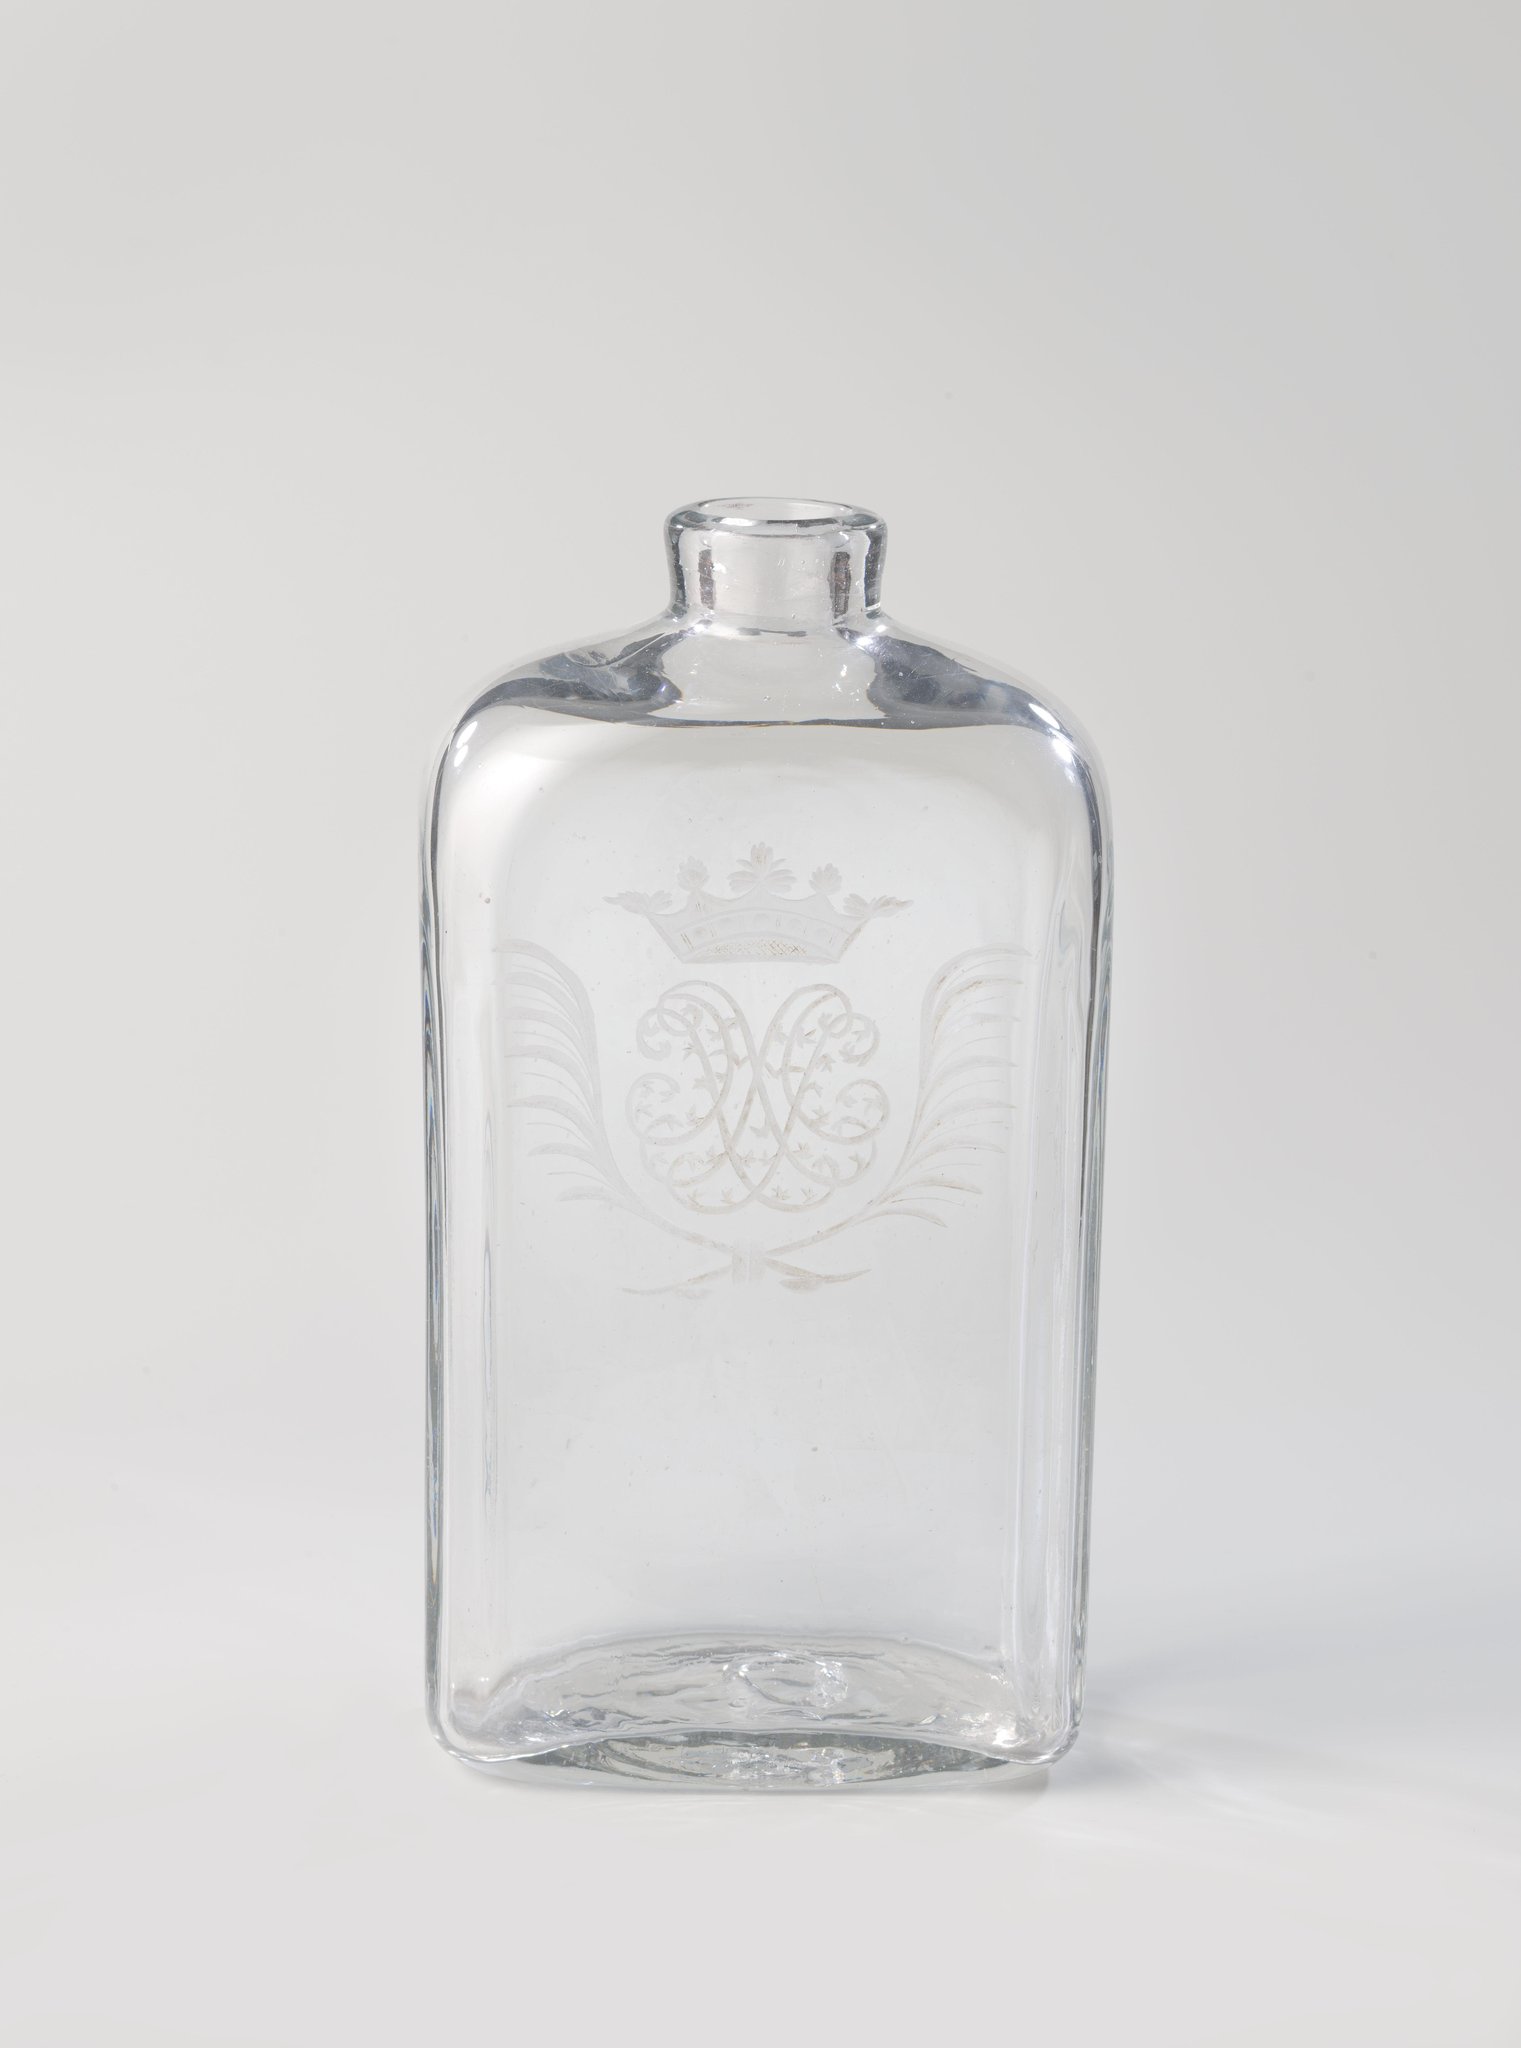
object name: bottle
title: Fles met een gekroond monogram (?)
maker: Anonymous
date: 1700-1750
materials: glass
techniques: glassblowing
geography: germany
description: Fles van helder, kleurloos glas. Platte bodem. Rechthoekig lichaam met afgeronde hoeken en schouders. Korte hals. Op het lichaam een gekroond monogram (?) tussen twee samengebonden lauwertakken.